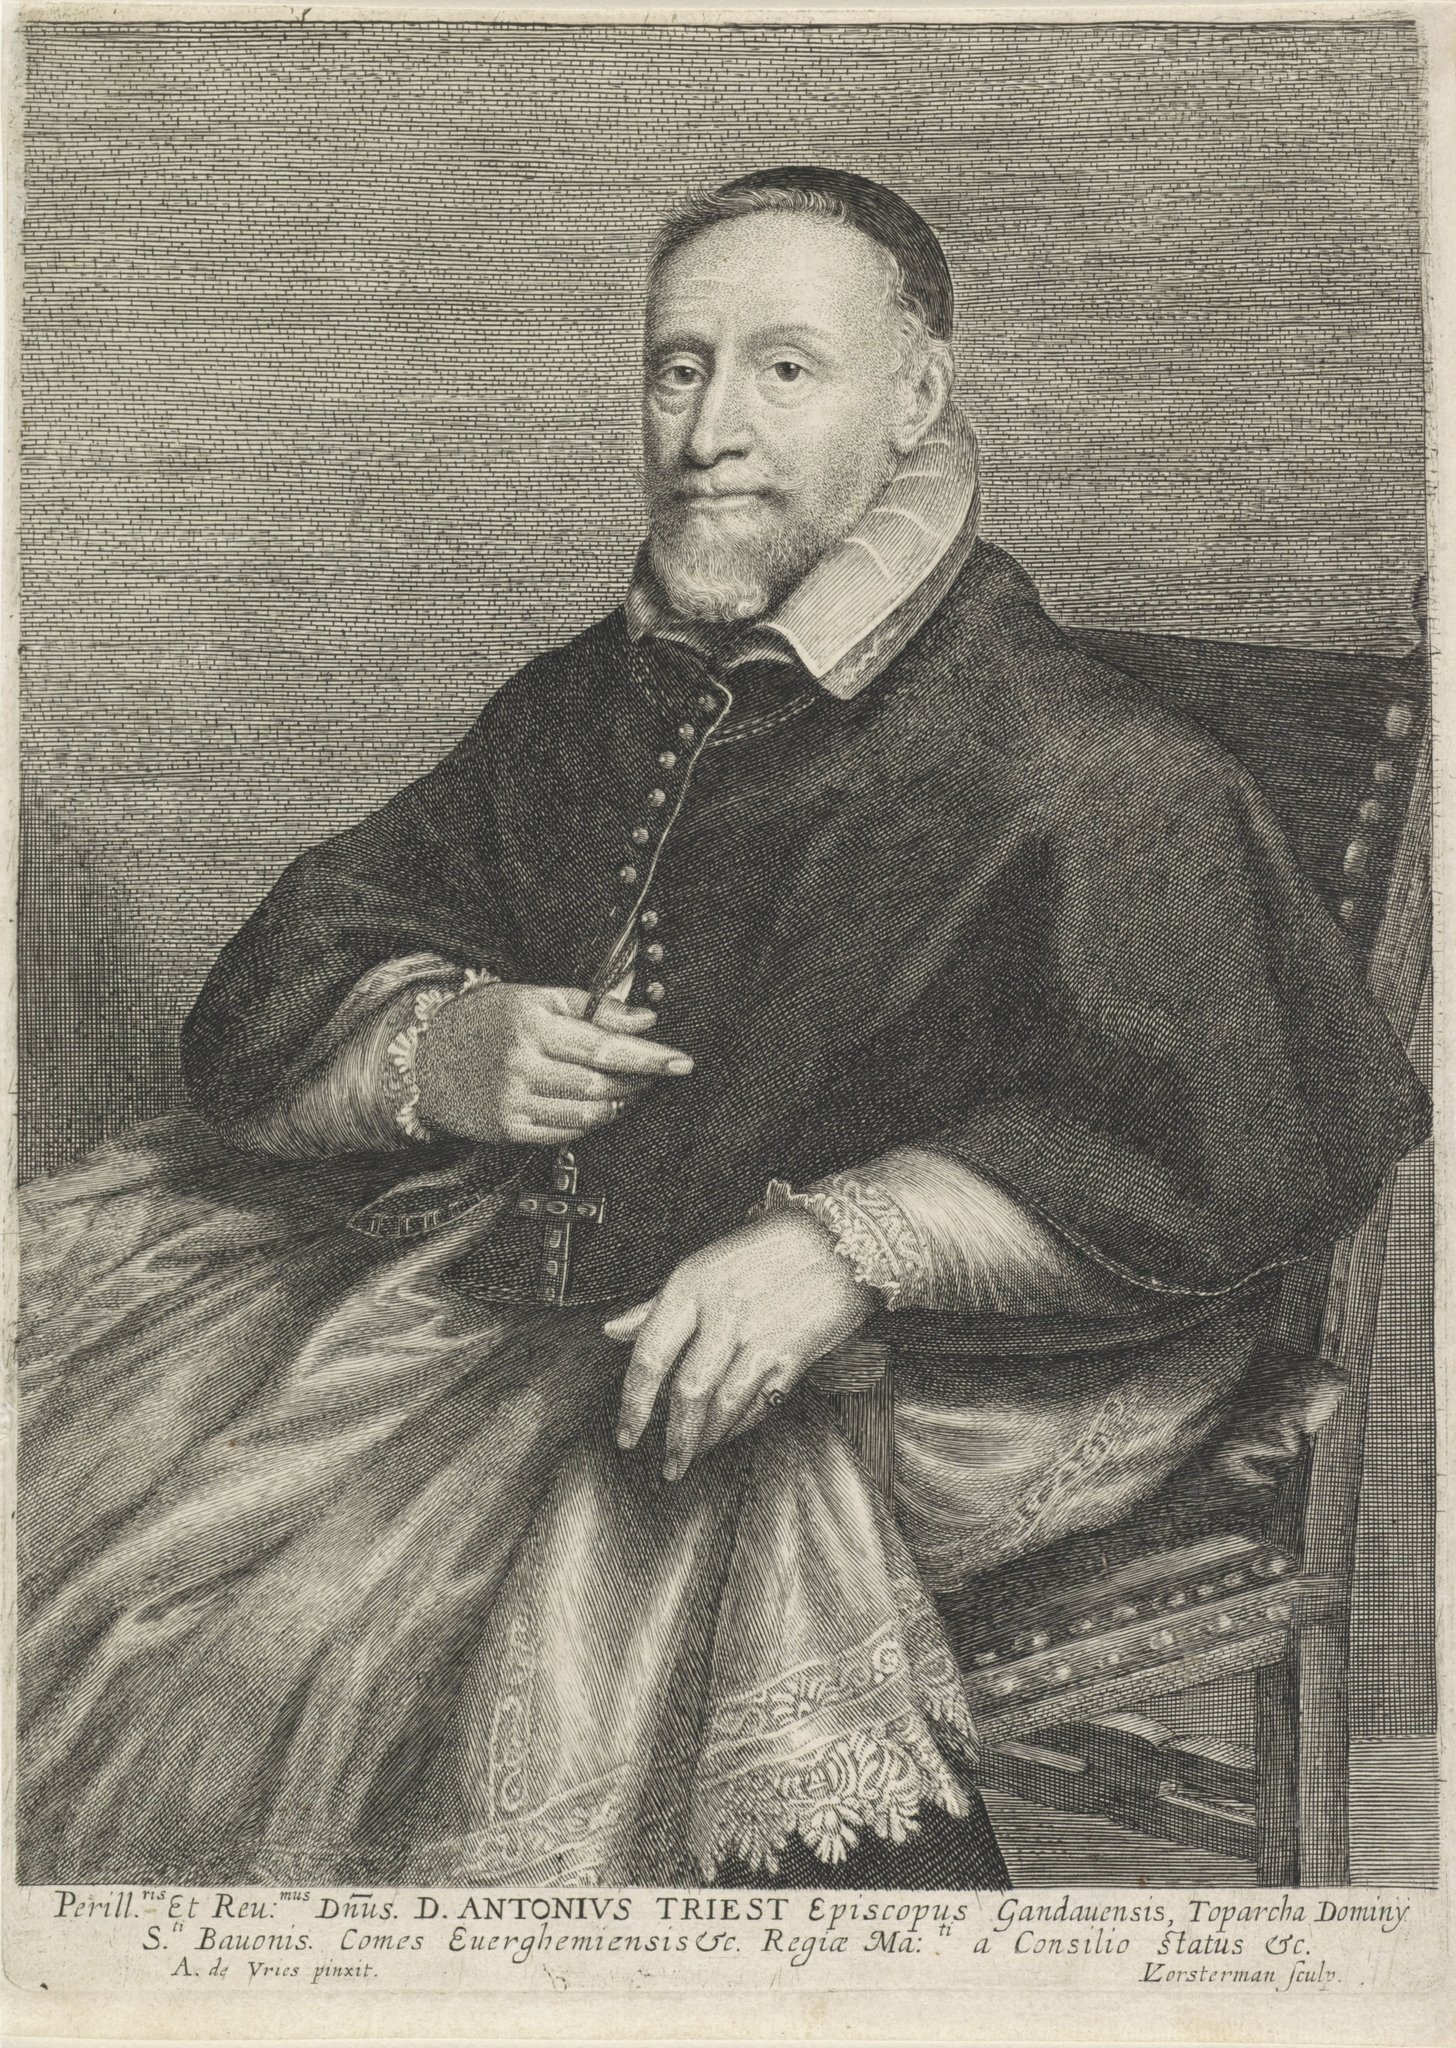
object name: print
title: Portret van bisschop Antonius Triest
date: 1620-1675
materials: paper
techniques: engraving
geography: antwerp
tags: ghent, antonius triest, archbishop, bishop, etc. (roman catholic)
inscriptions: collector's mark: Lugt 2228